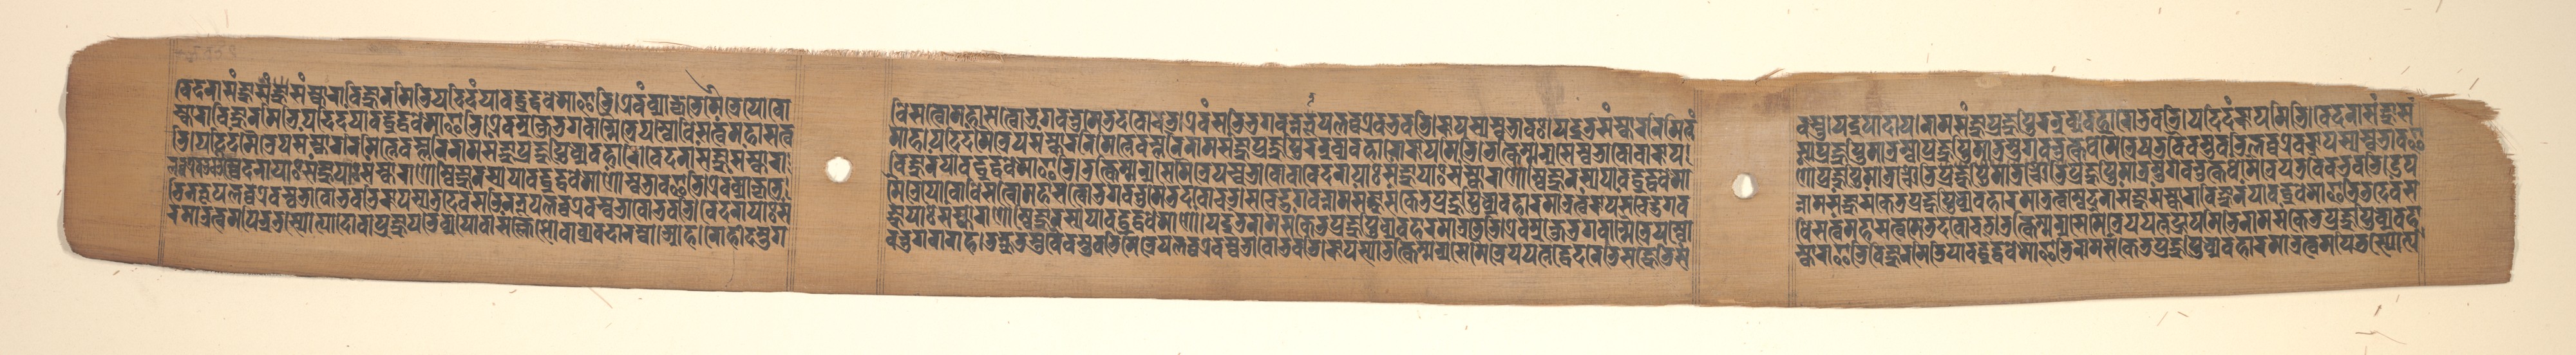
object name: folio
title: Folio from a Buddhist Manuscript of Pancavimsatisahasrika Prajnaparamita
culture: indian, bengal or bangladesh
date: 1090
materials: leaf, watercolor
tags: buddhism